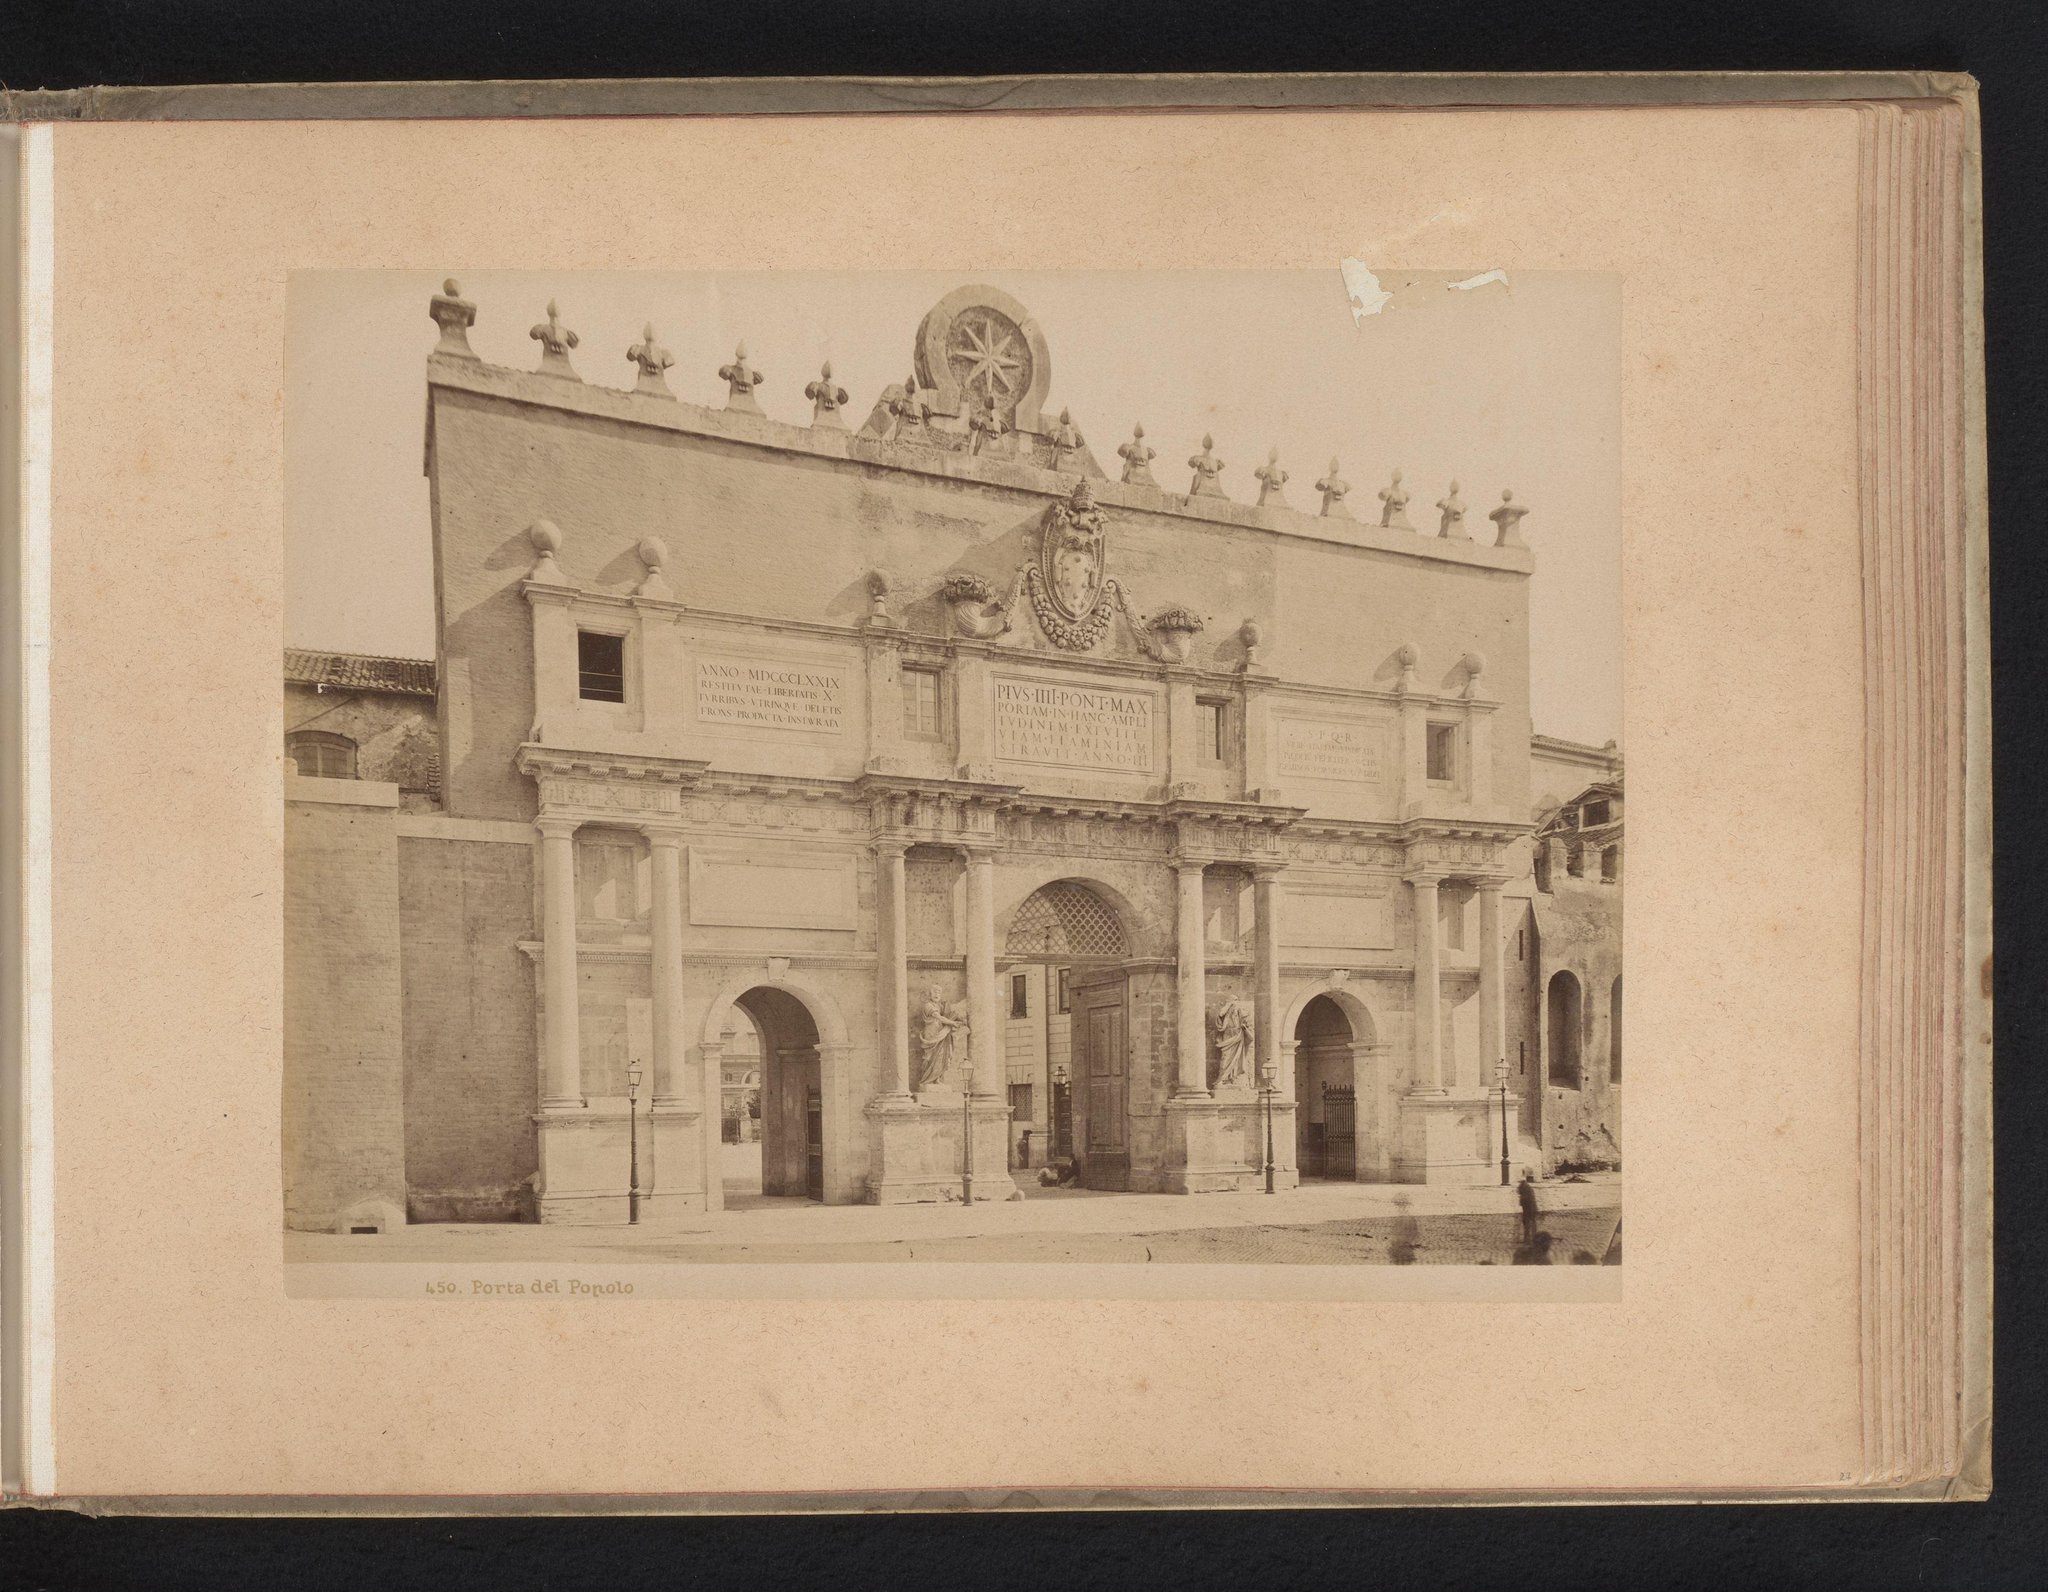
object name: photograph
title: Gezicht op de Porta del Popolo in Rome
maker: Anonymous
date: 1870-1895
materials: cardboard, photographic support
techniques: albumen print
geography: rome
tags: city-gate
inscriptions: inscription: ‘450. Porta del Popolo’